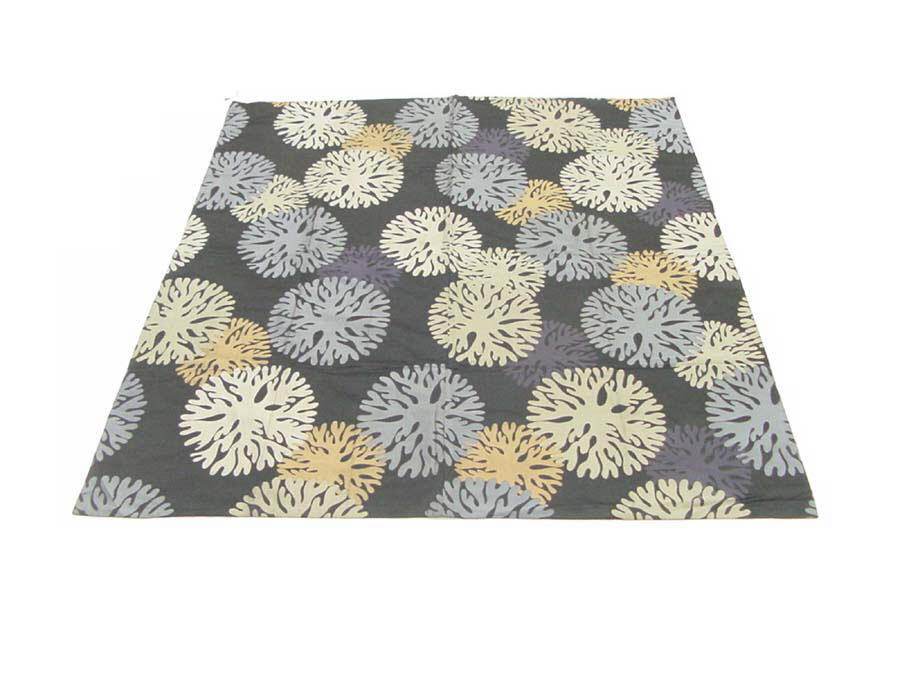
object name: altar cloth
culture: japanese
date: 1801-1900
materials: silk